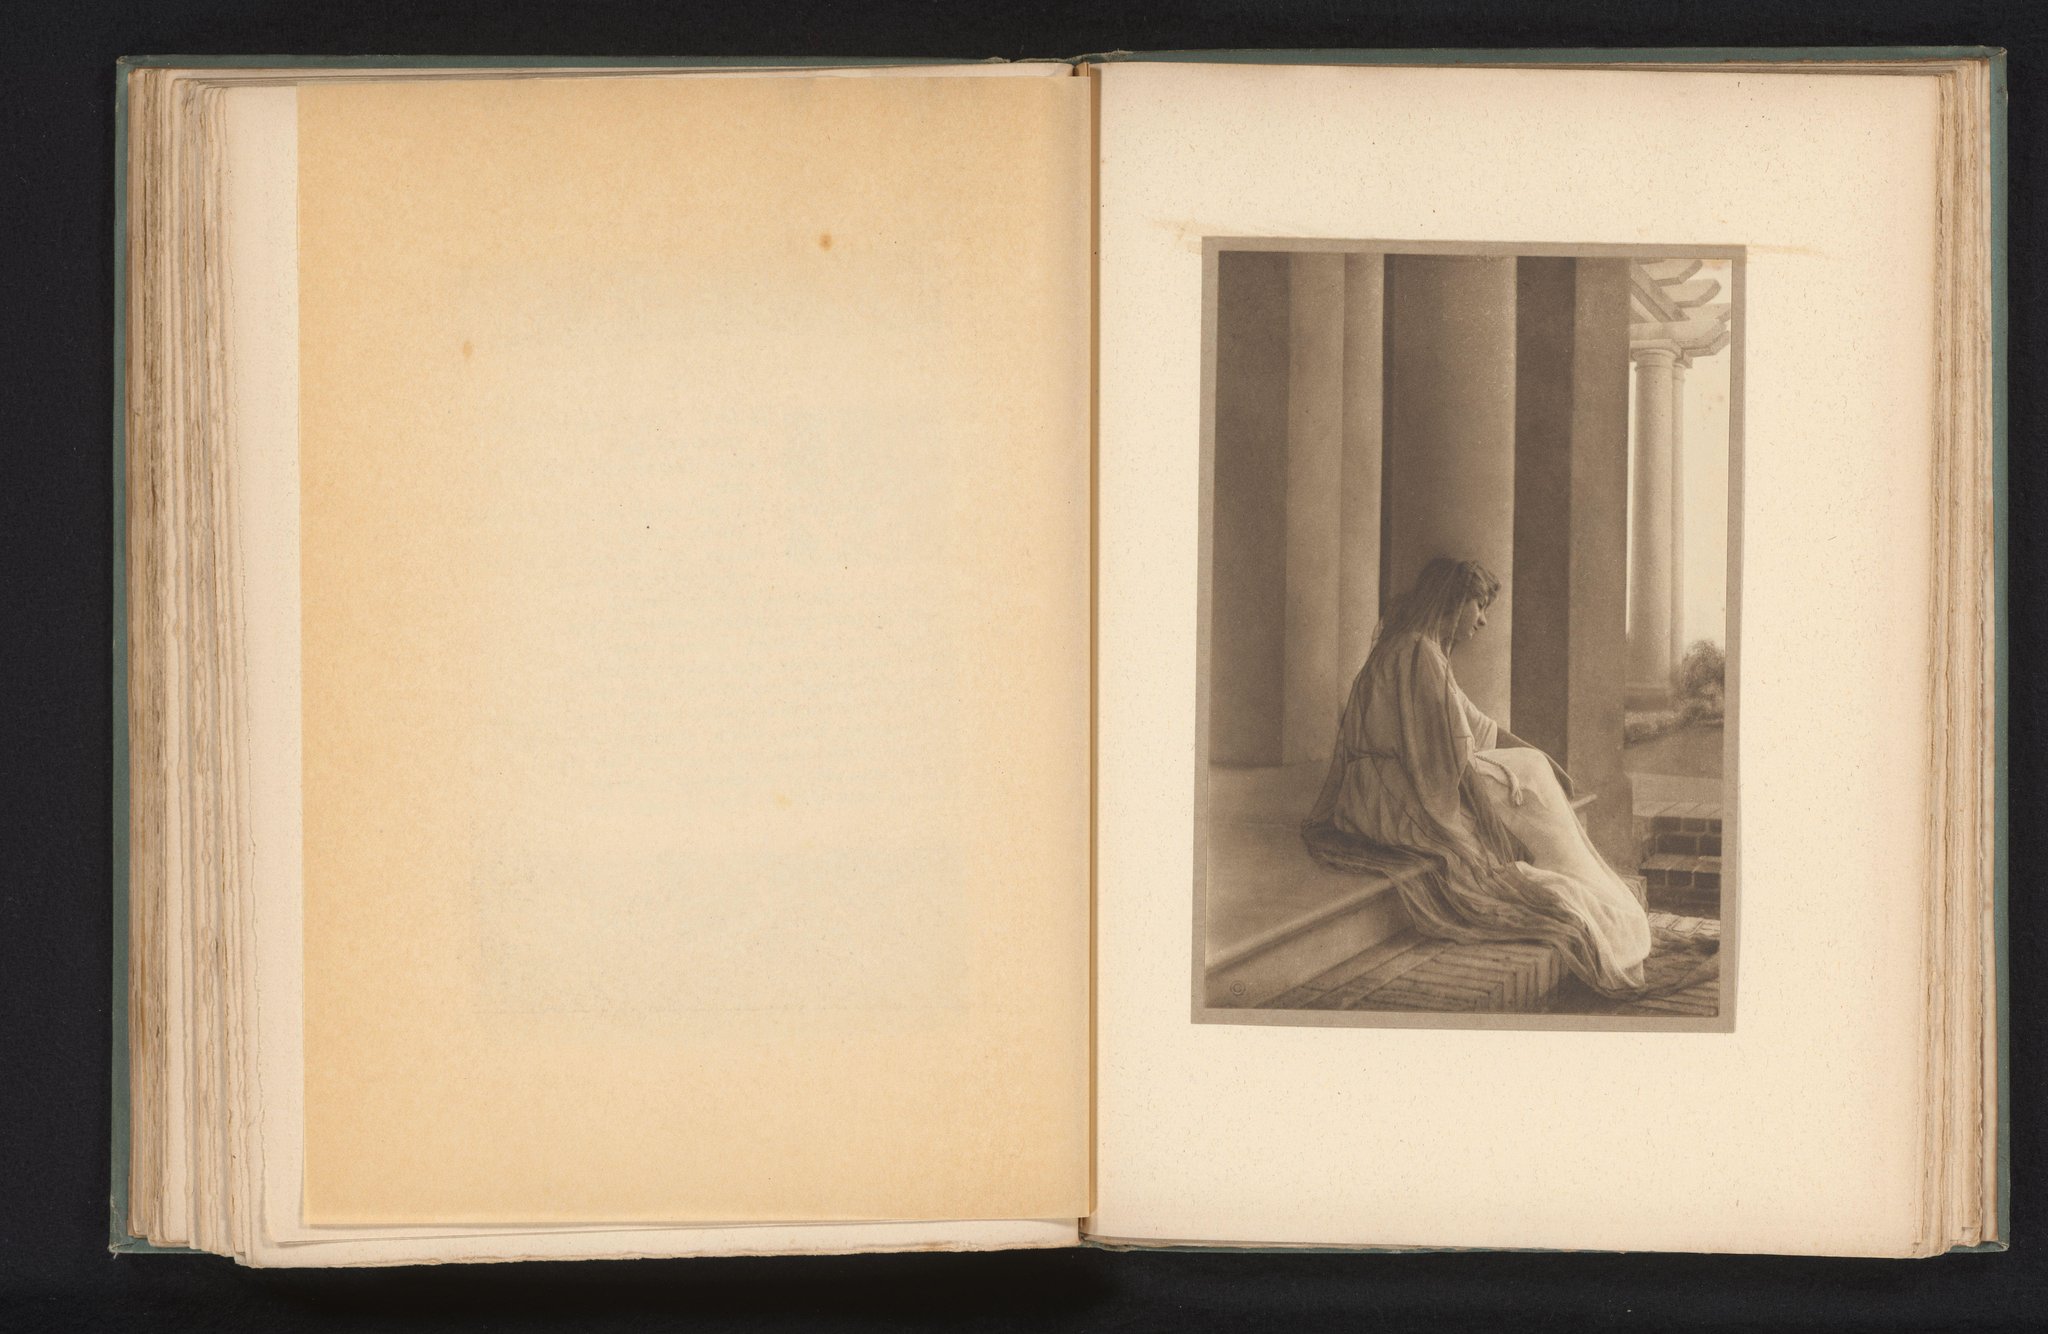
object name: page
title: Vrouw zittend op trede van tempelportaal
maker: adelaide hanscom leeson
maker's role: painter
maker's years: 1875-1931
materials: cardboard, paper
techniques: photoaquatint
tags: adult woman, front steps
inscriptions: inscription: ‘O’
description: Prent op ongenummerde pagina. Adelaide Hanscom Leeson manipuleerde haar glasnegatieven om een schilderachtig efffect te bewerkstelligen.